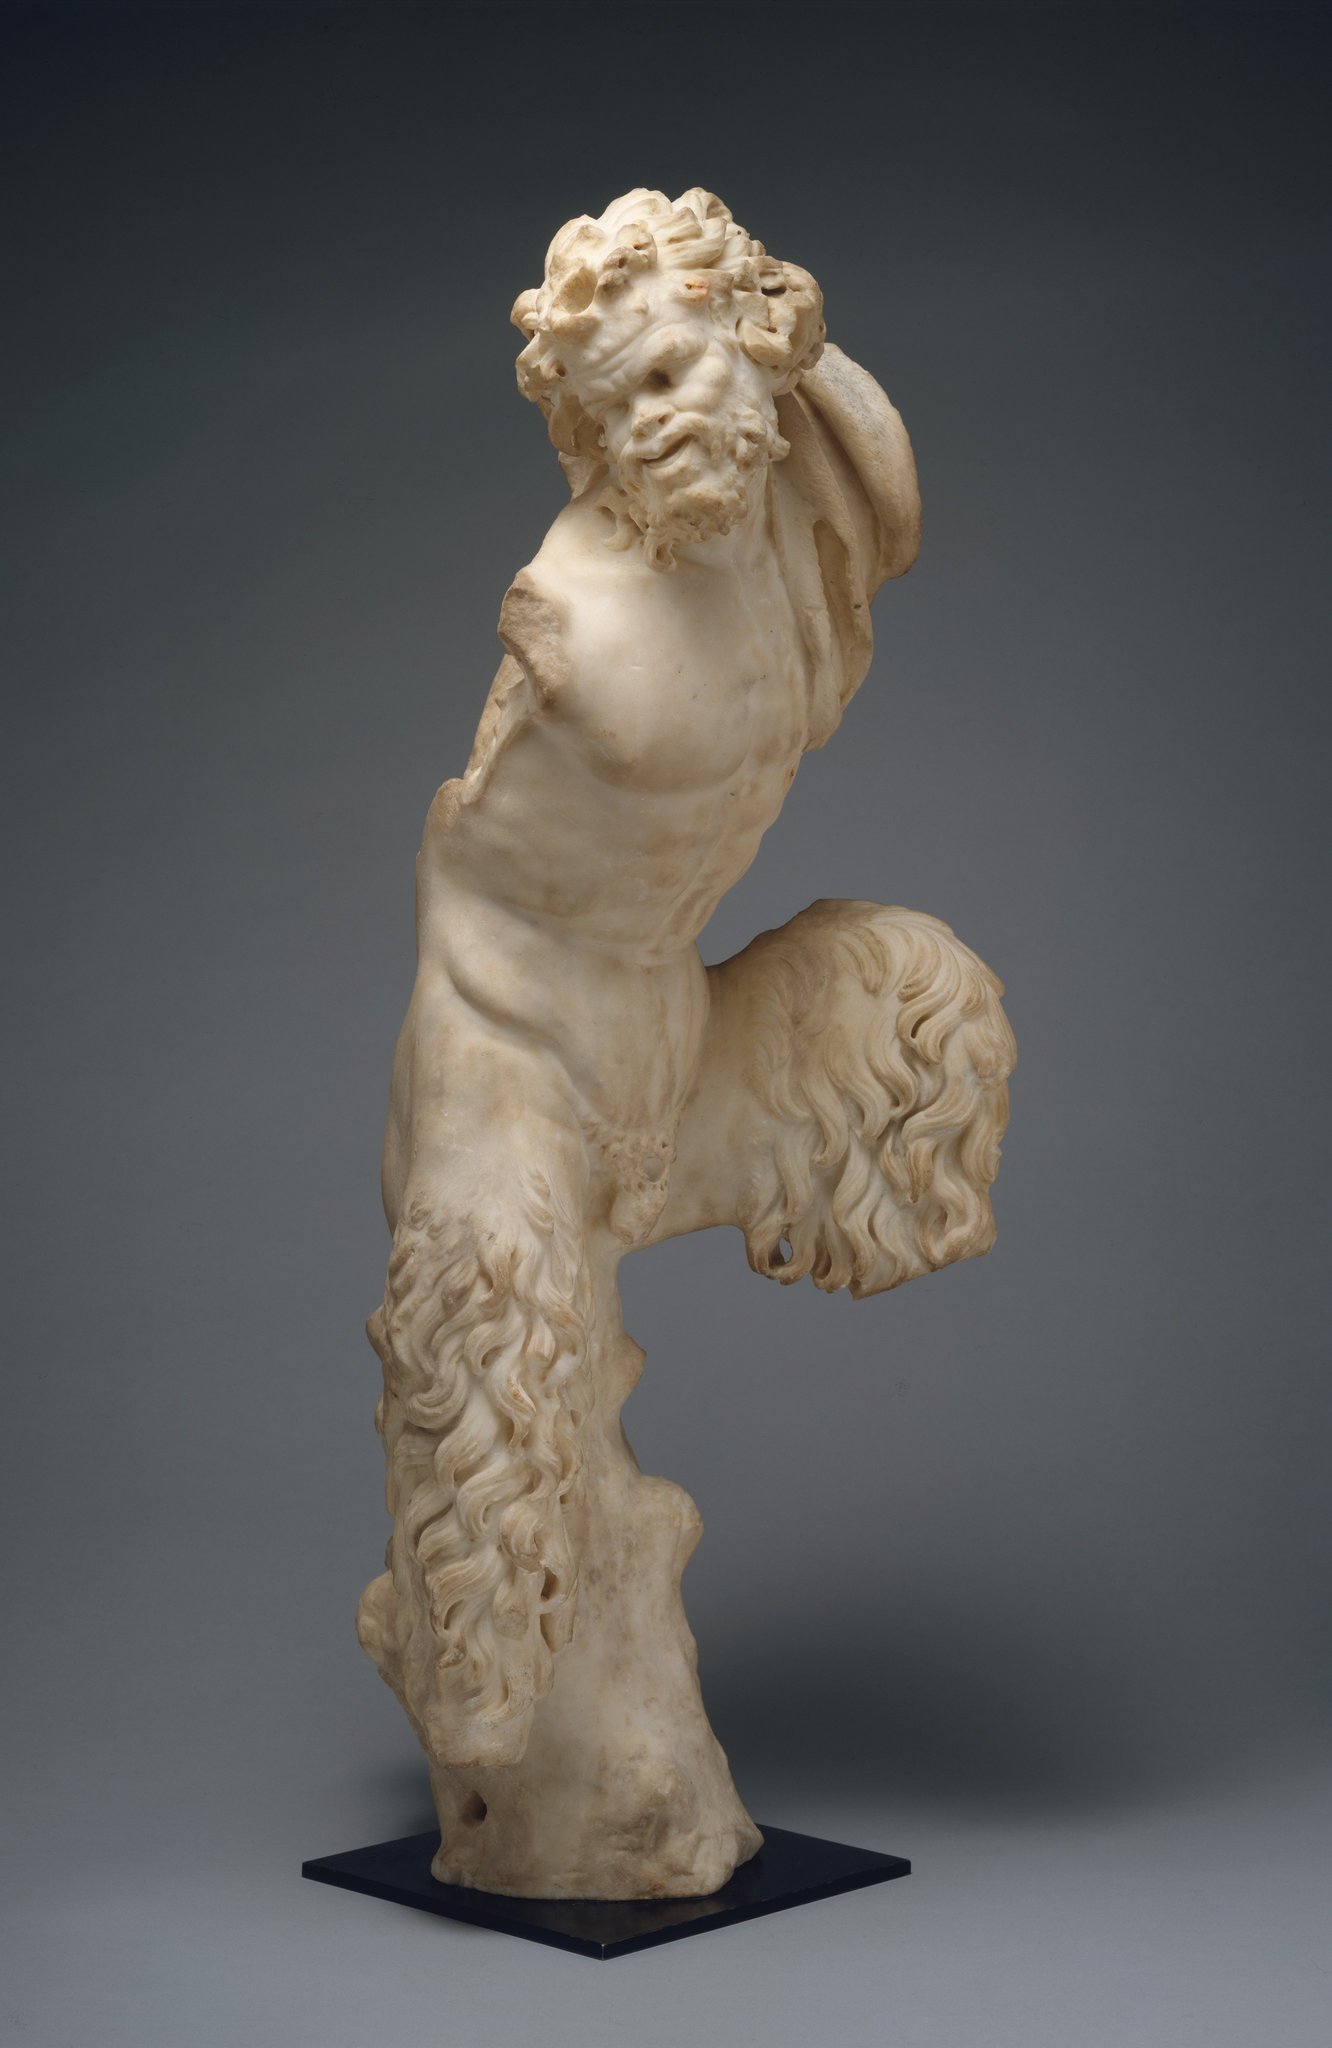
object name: statue of pan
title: Marble statue of Pan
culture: roman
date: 1-100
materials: marble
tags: pan